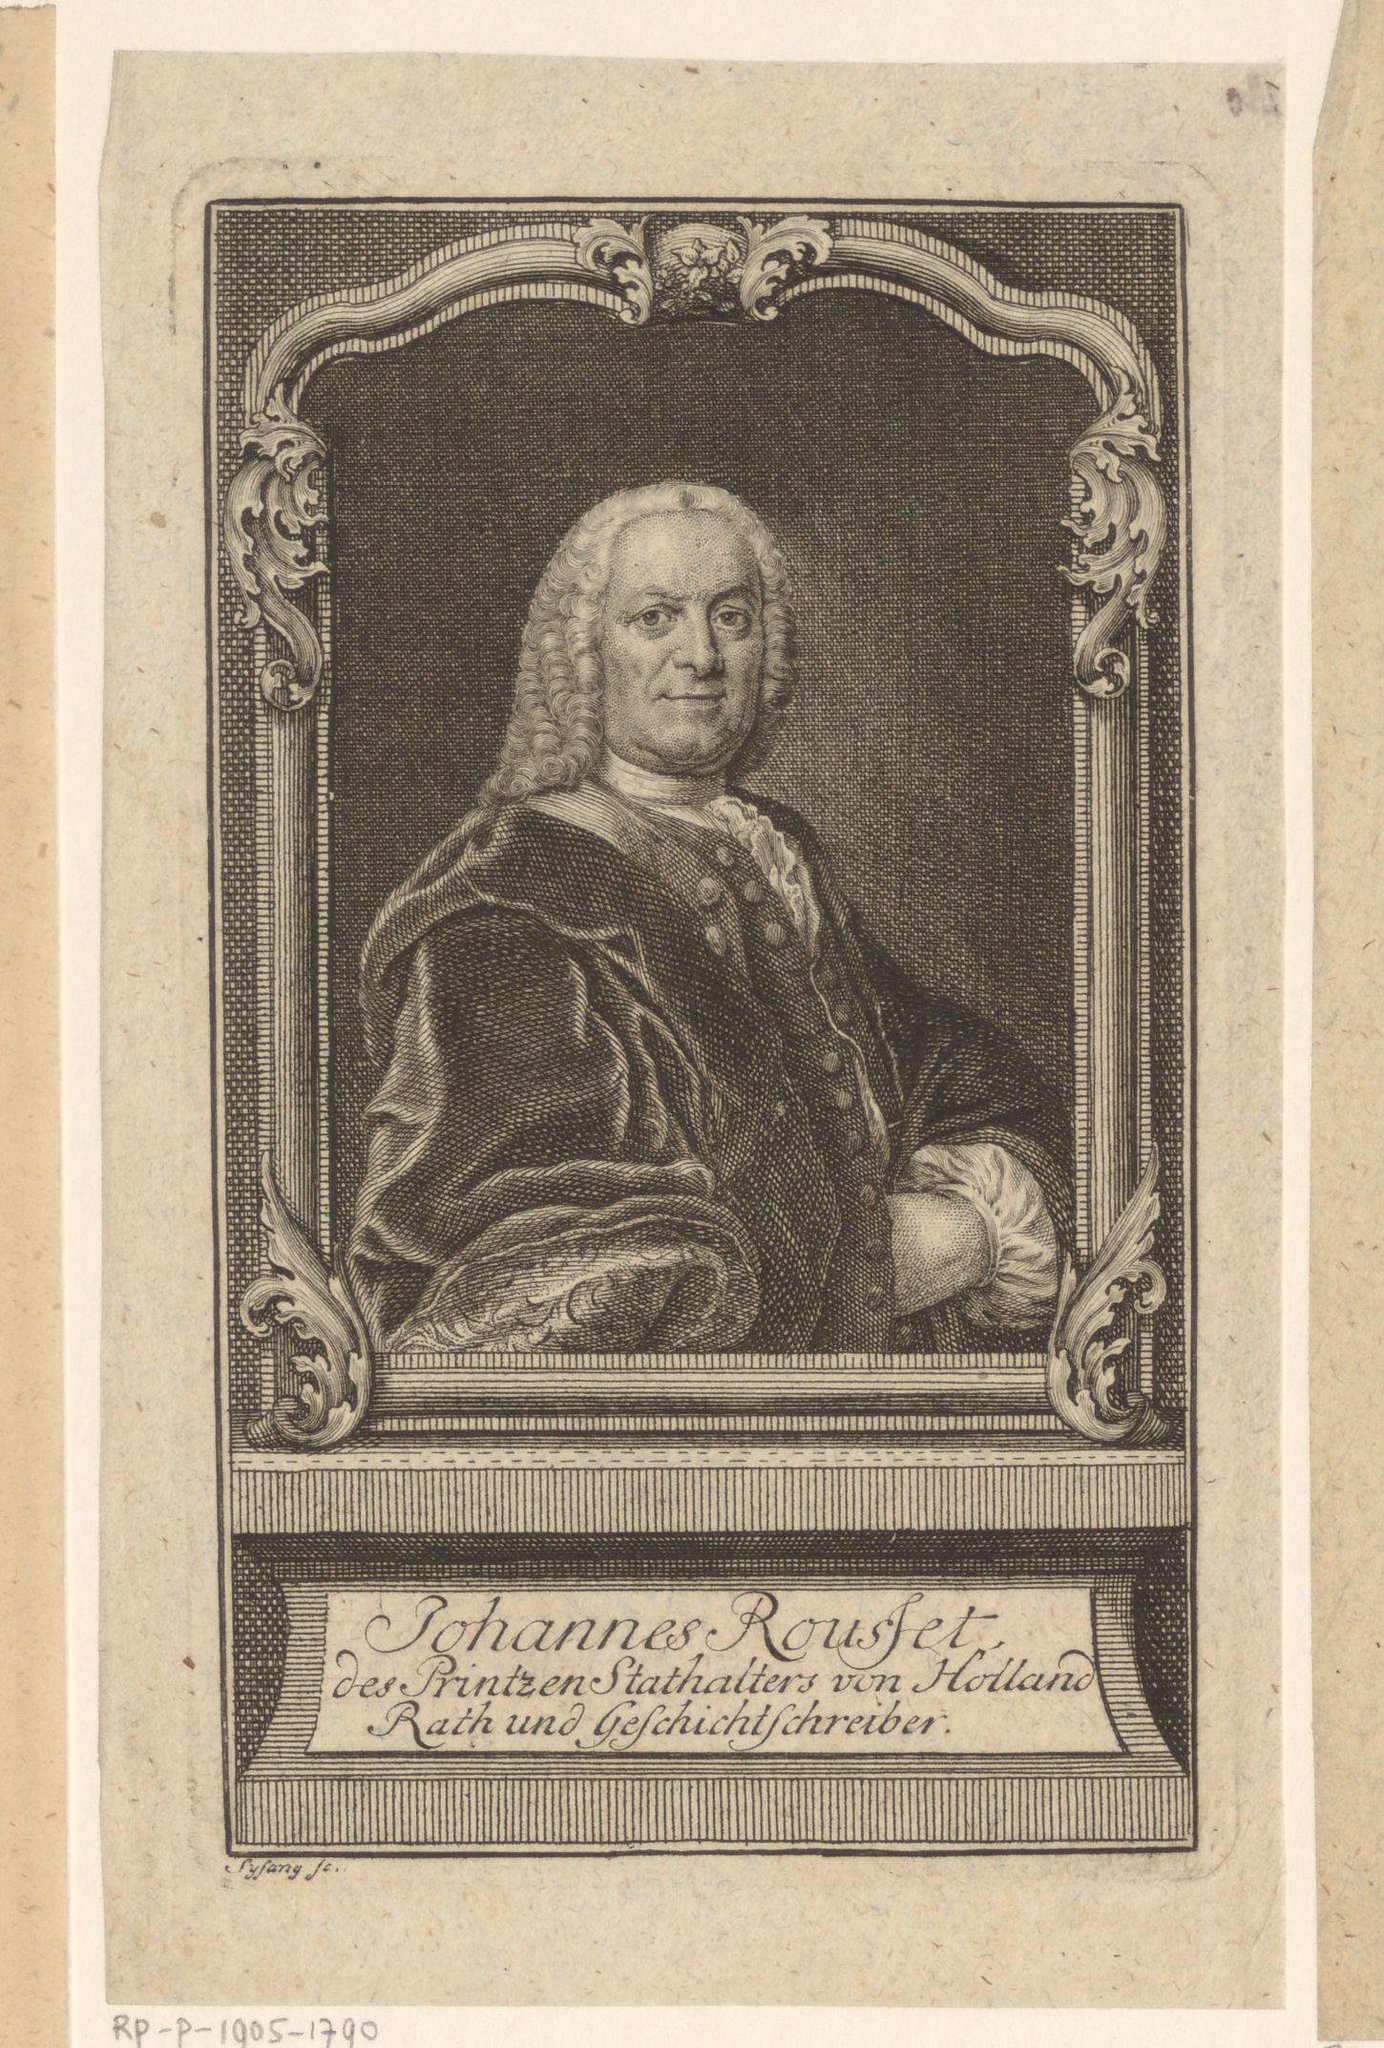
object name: print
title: Portret van Jean Rousset de Missy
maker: johann christoph sysang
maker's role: print maker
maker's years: 1703-1757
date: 1749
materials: paper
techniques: engraving, etching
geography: leipzig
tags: historical persons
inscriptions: collector's mark: Lugt 2228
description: Prent gebruikt voor de publicatie: Zuverlässige Nachrichten von dem gegenwärtigen Zustande, Veränderung und Wachsthum der Wissenschaften. Leipzig: Johann Friedrich Gleditsch, 1749, dl. 109.